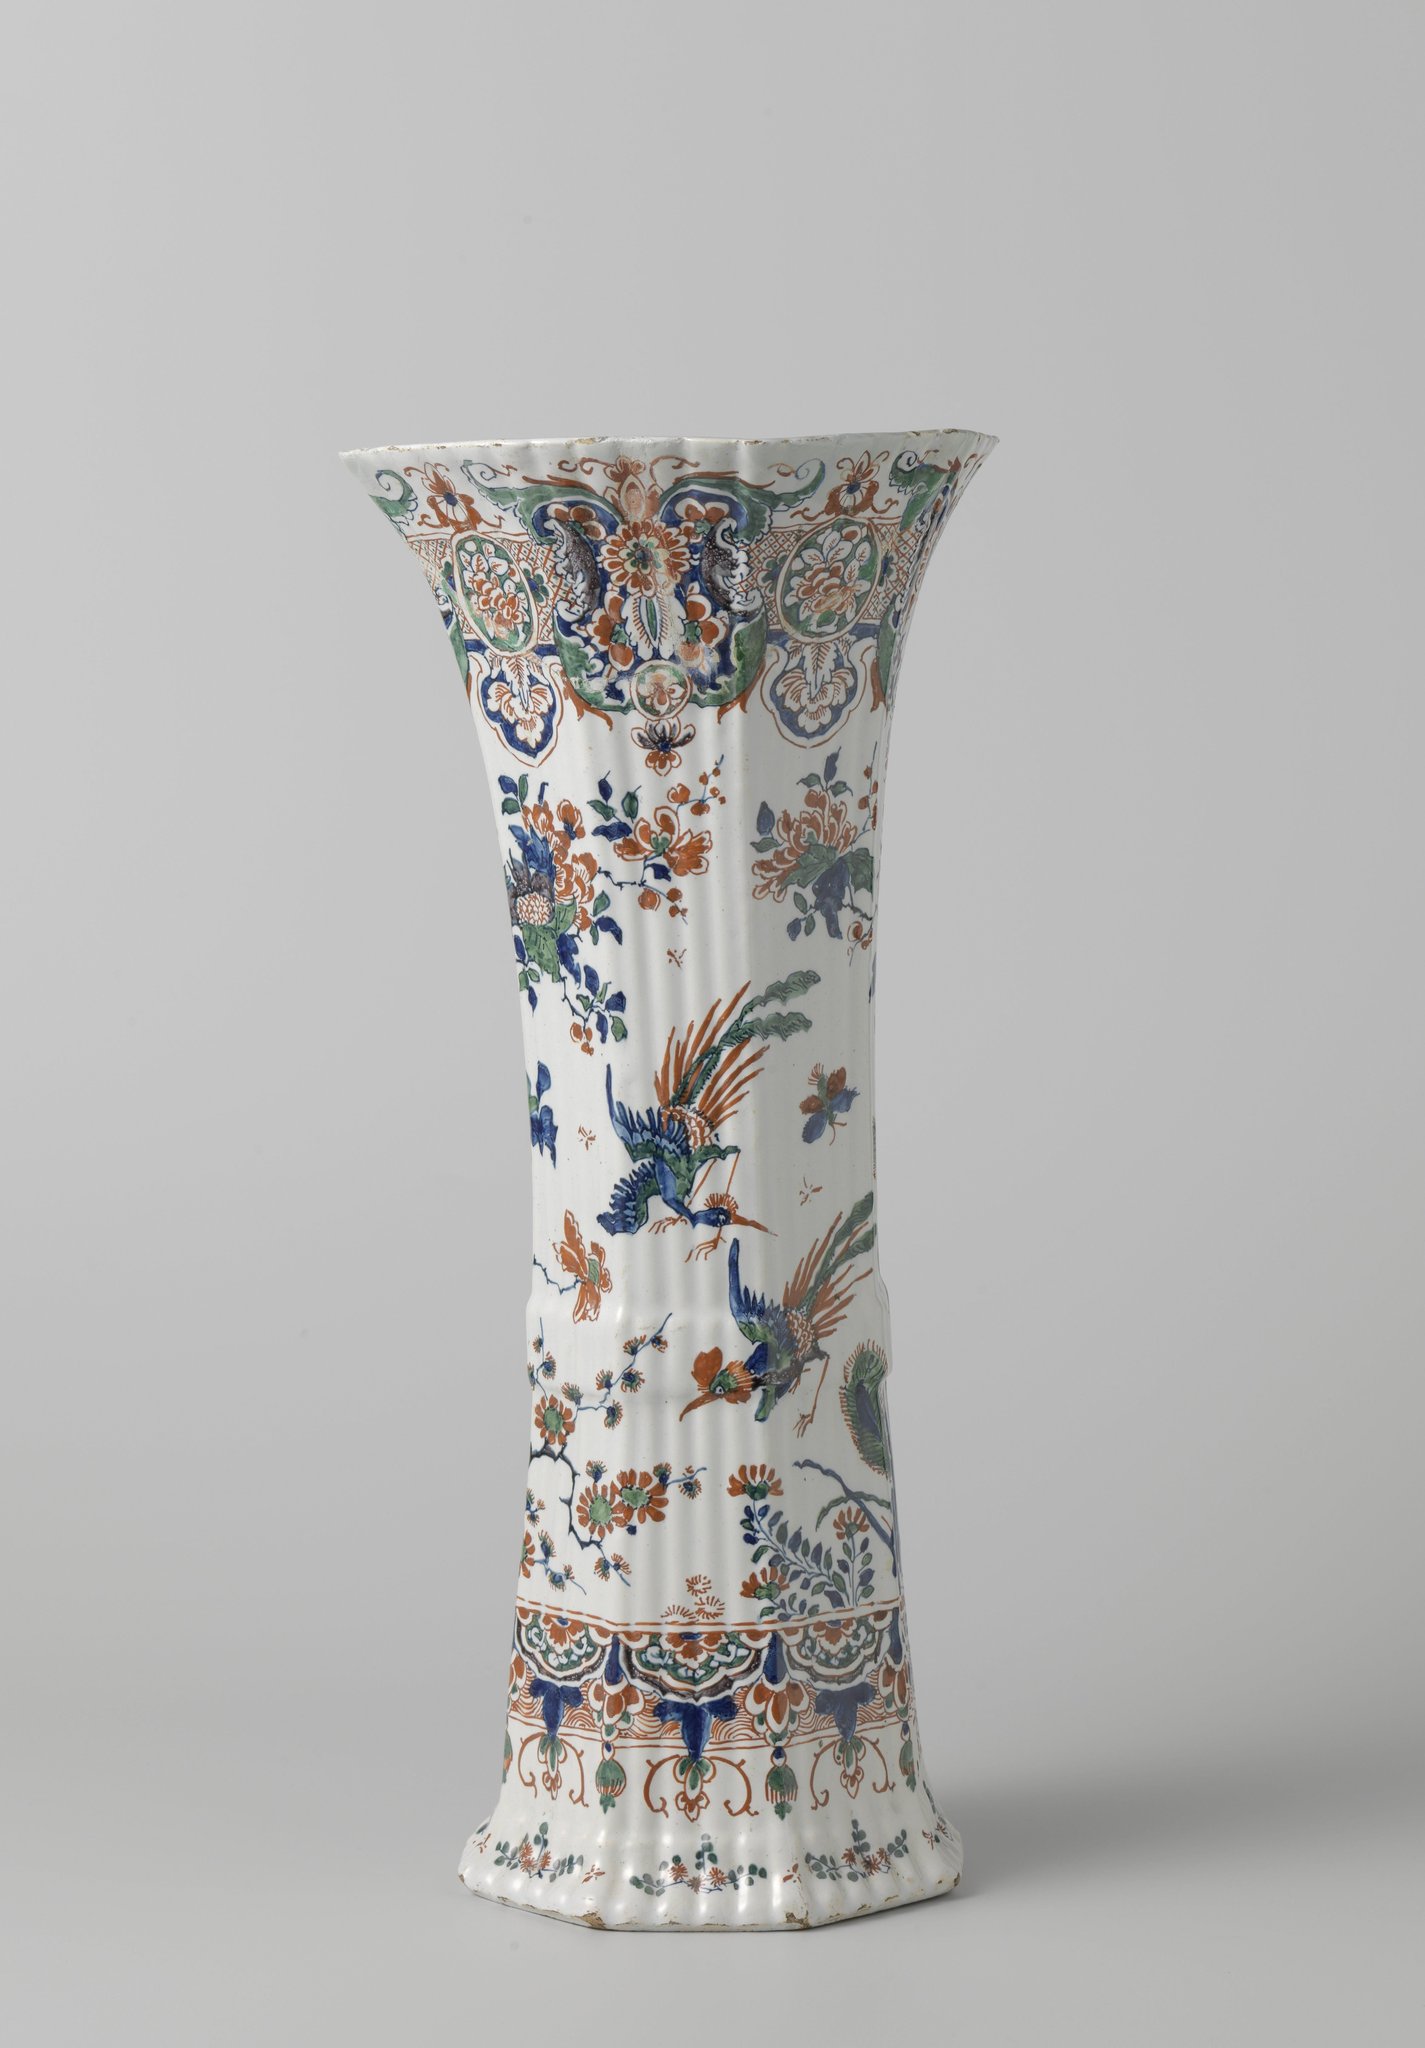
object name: kaststel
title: Achtkantige geribde pot van veelkleurig beschilderde faïence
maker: lambertus van eenhoorn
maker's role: plateelbakker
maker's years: 1651-1721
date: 1695-1725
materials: earthenware, glaze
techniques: painted, polychromy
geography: delft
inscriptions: mark: ‘LVE (ineen)/ IVK (ineen) / 3 / 0’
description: Cabinet set. Faience. Delft, 'De Dobbelde Schenckan', under Louwijs Fictoor, c. 1700. Presented by the heirs of John F. Loudon, 1916.